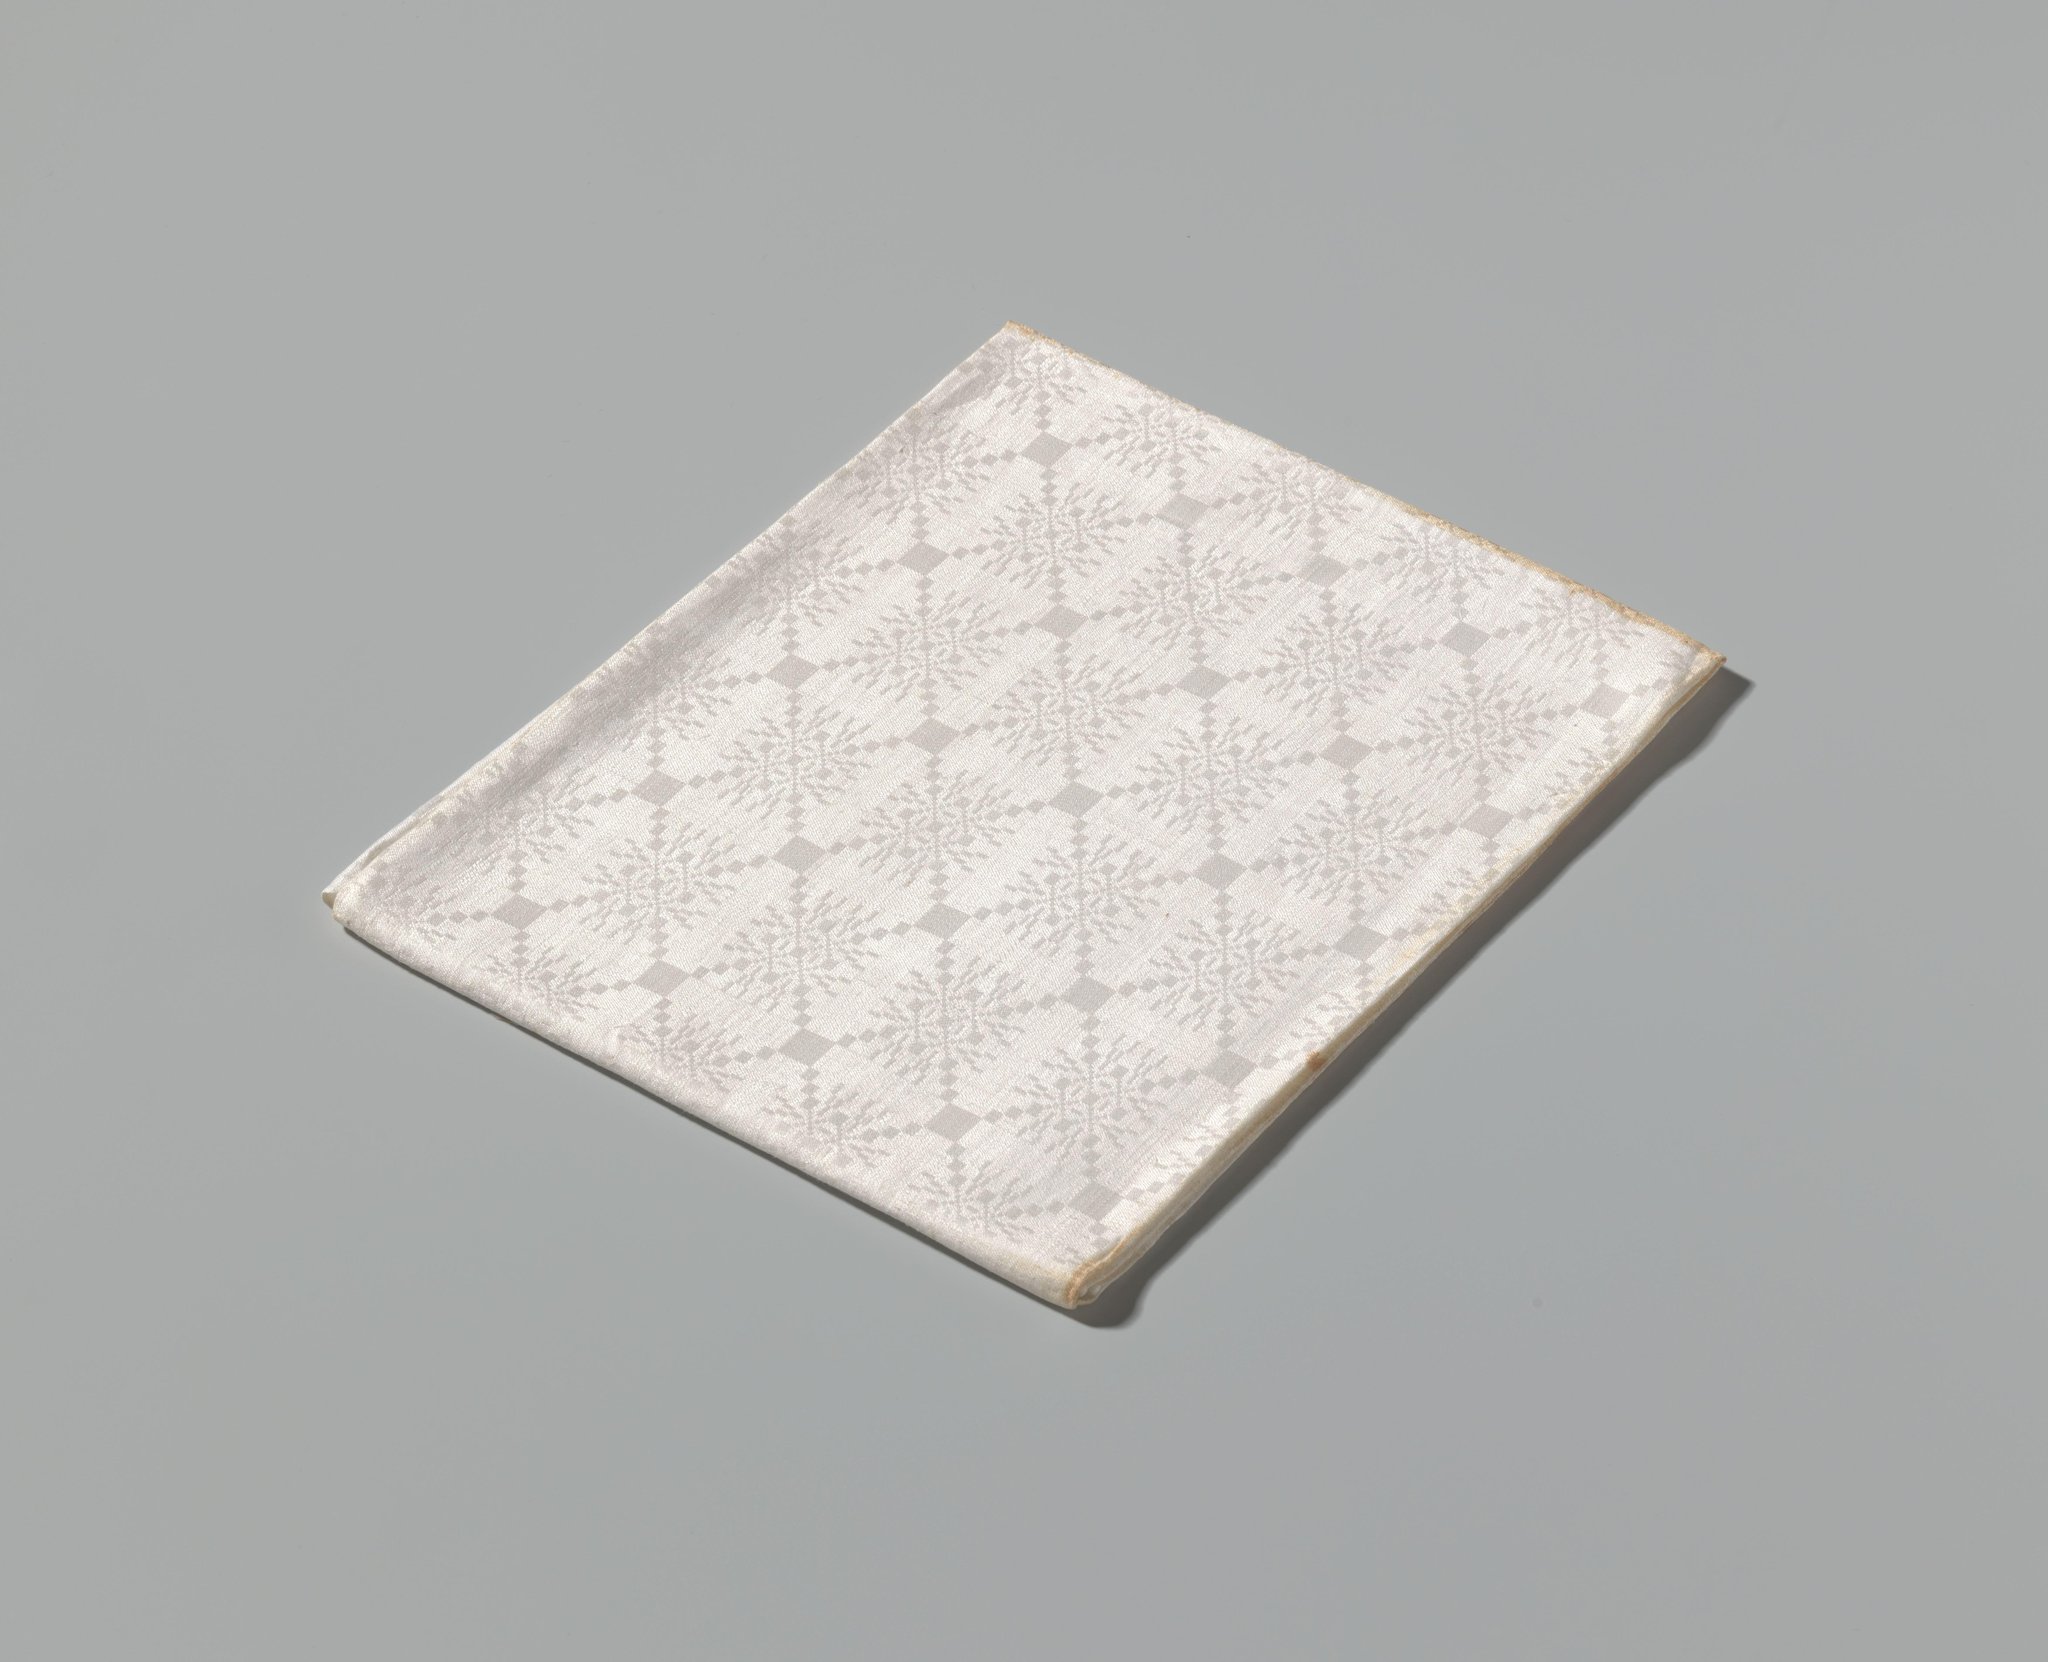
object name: napkin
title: Servet van wit linnen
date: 1734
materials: linen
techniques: peeled fabric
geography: netherlands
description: Wit linnen servet met een pellenpatroon, genaamd "fijne Italiaanse vloer". Merk kroon WG 54 en 1734.